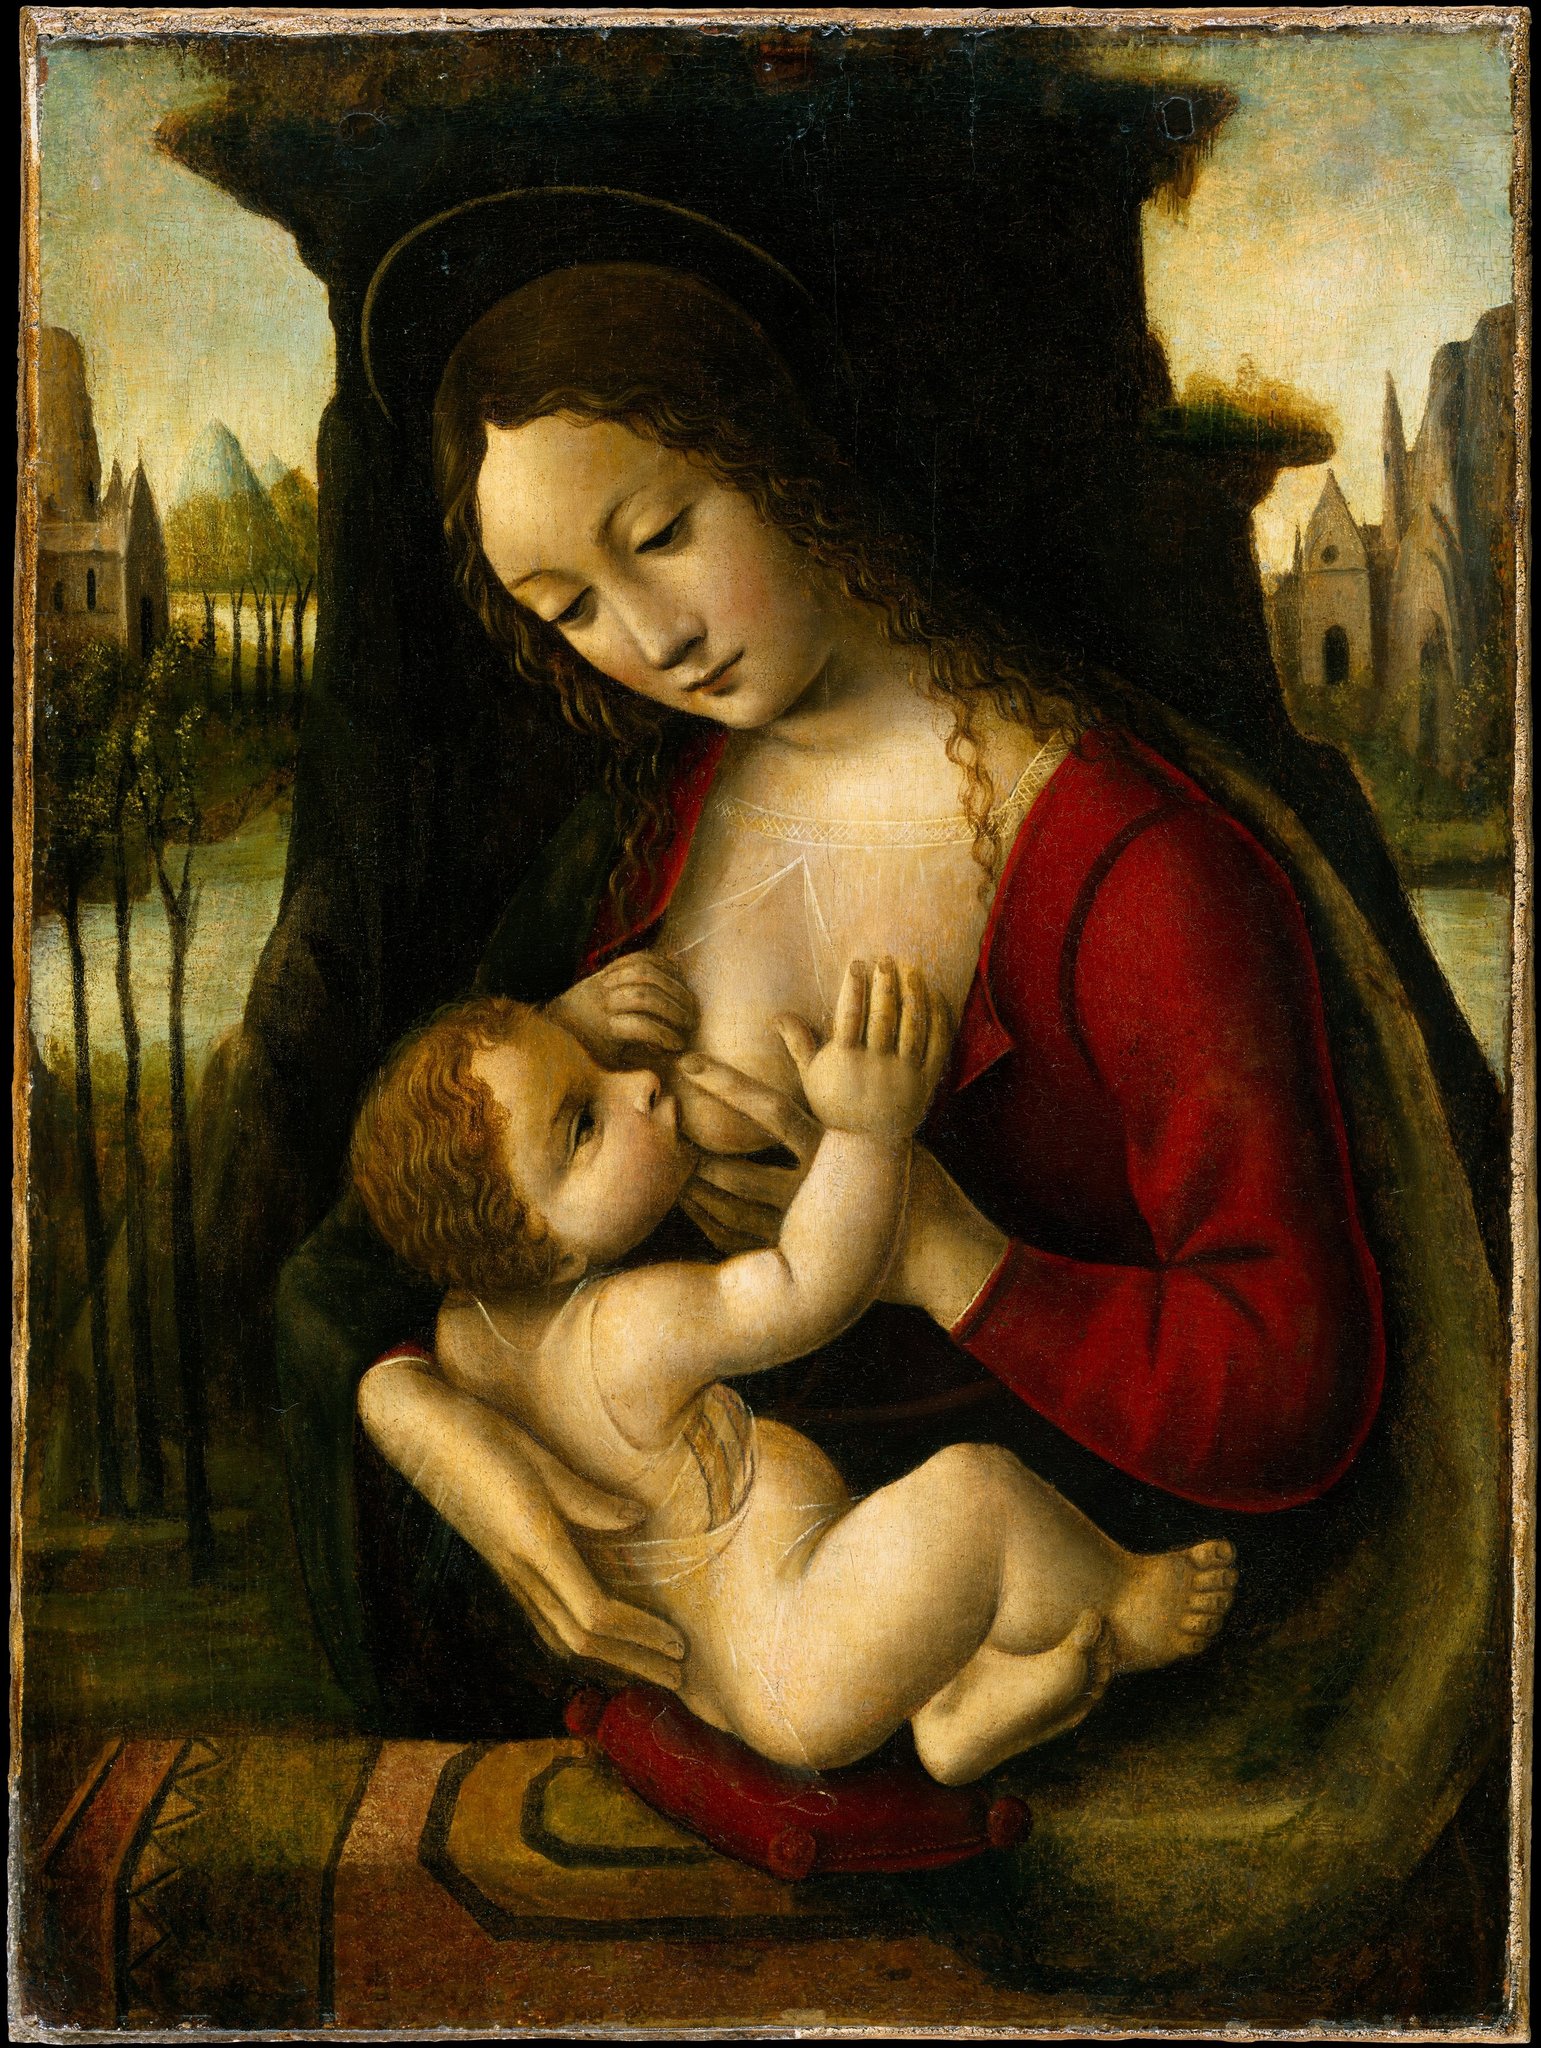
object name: painting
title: Madonna and Child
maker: bernardino dei conti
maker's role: artist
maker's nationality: italian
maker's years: 1496-1522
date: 1516-1522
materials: oil, wood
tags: madonna and child,nursing